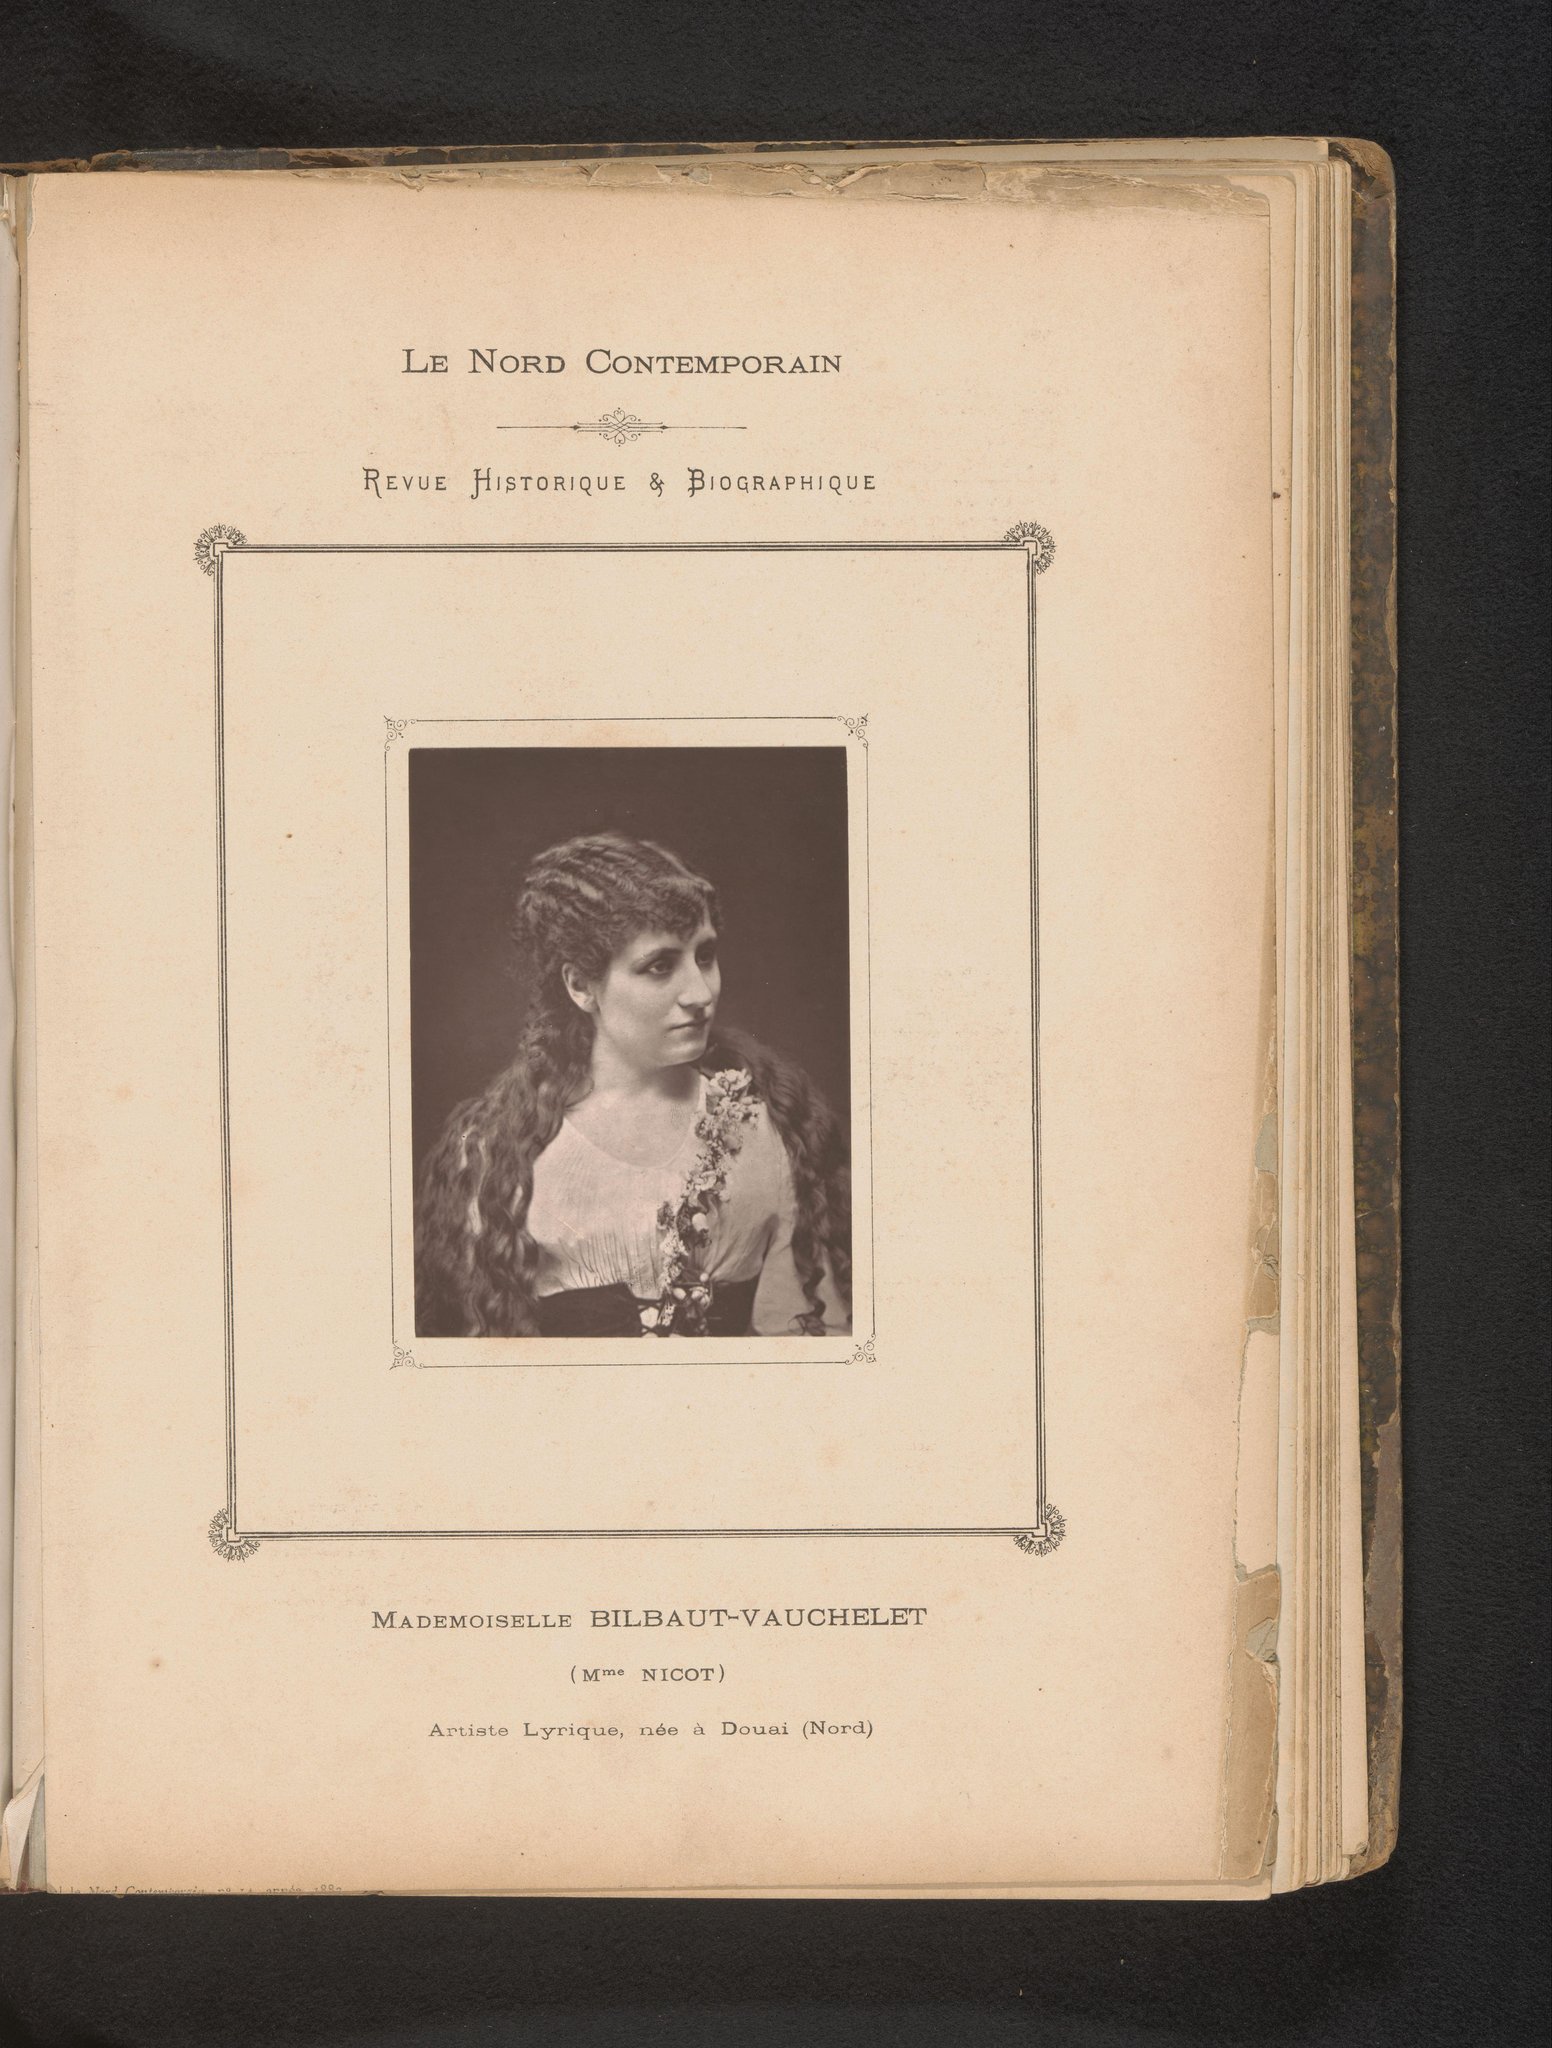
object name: photomechanical print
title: Portret van Juliette Bilbaut-Vauchelet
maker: Anonymous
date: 1878-1882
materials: paper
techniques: woodburytype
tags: historical persons - bb - woman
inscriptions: inscription: ‘(Mme Nicot)/ Ariste Lyrique, née à Douai (Nord)’, inscription: ‘Le Nord Contemporain/ Revue Historique & Biographique’